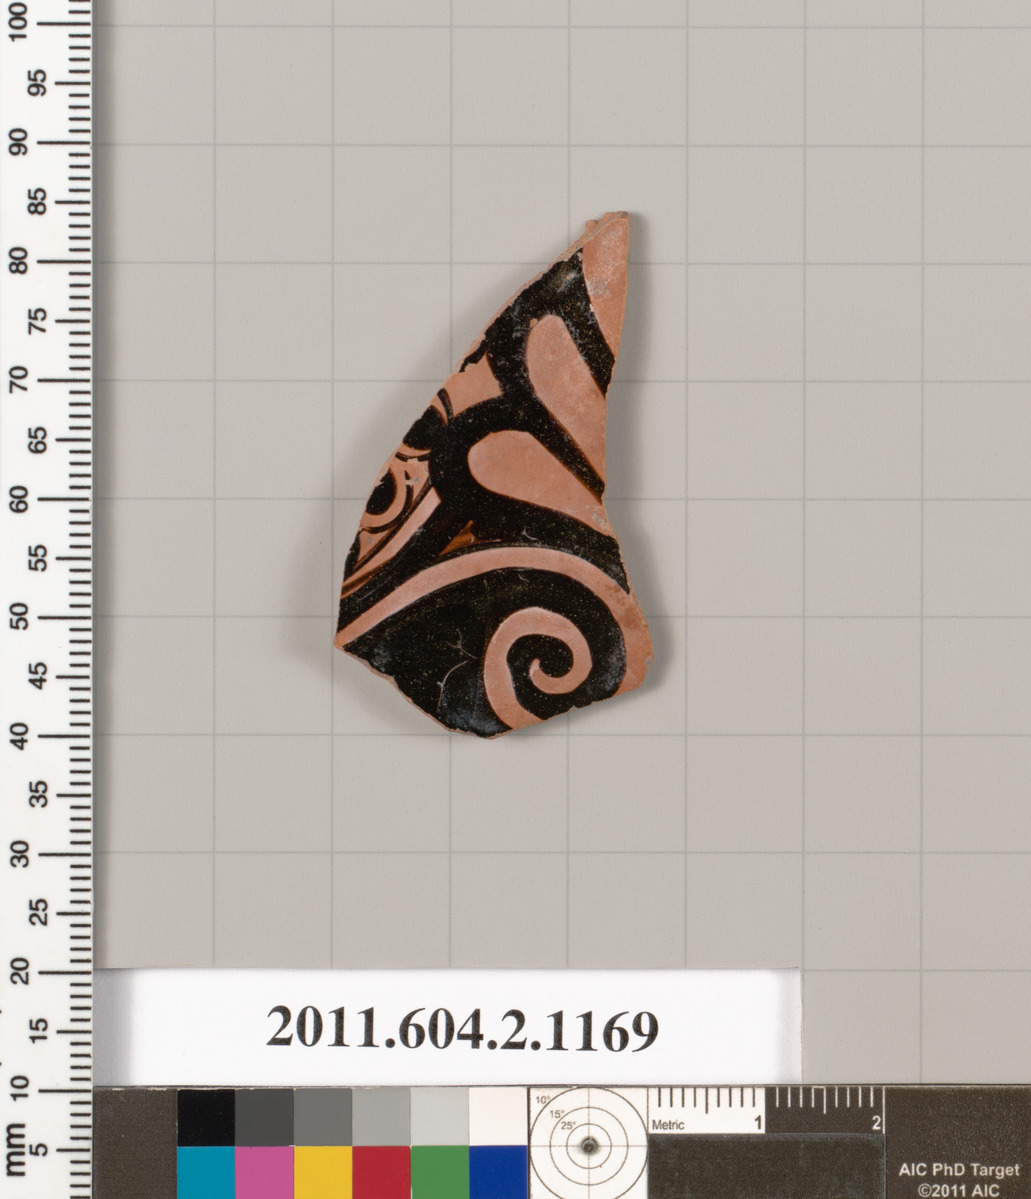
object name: kalpis fragment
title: Terracotta fragment of a hydria: kalpis (water jar)?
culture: greek, attic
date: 475-451 BCE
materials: terracotta